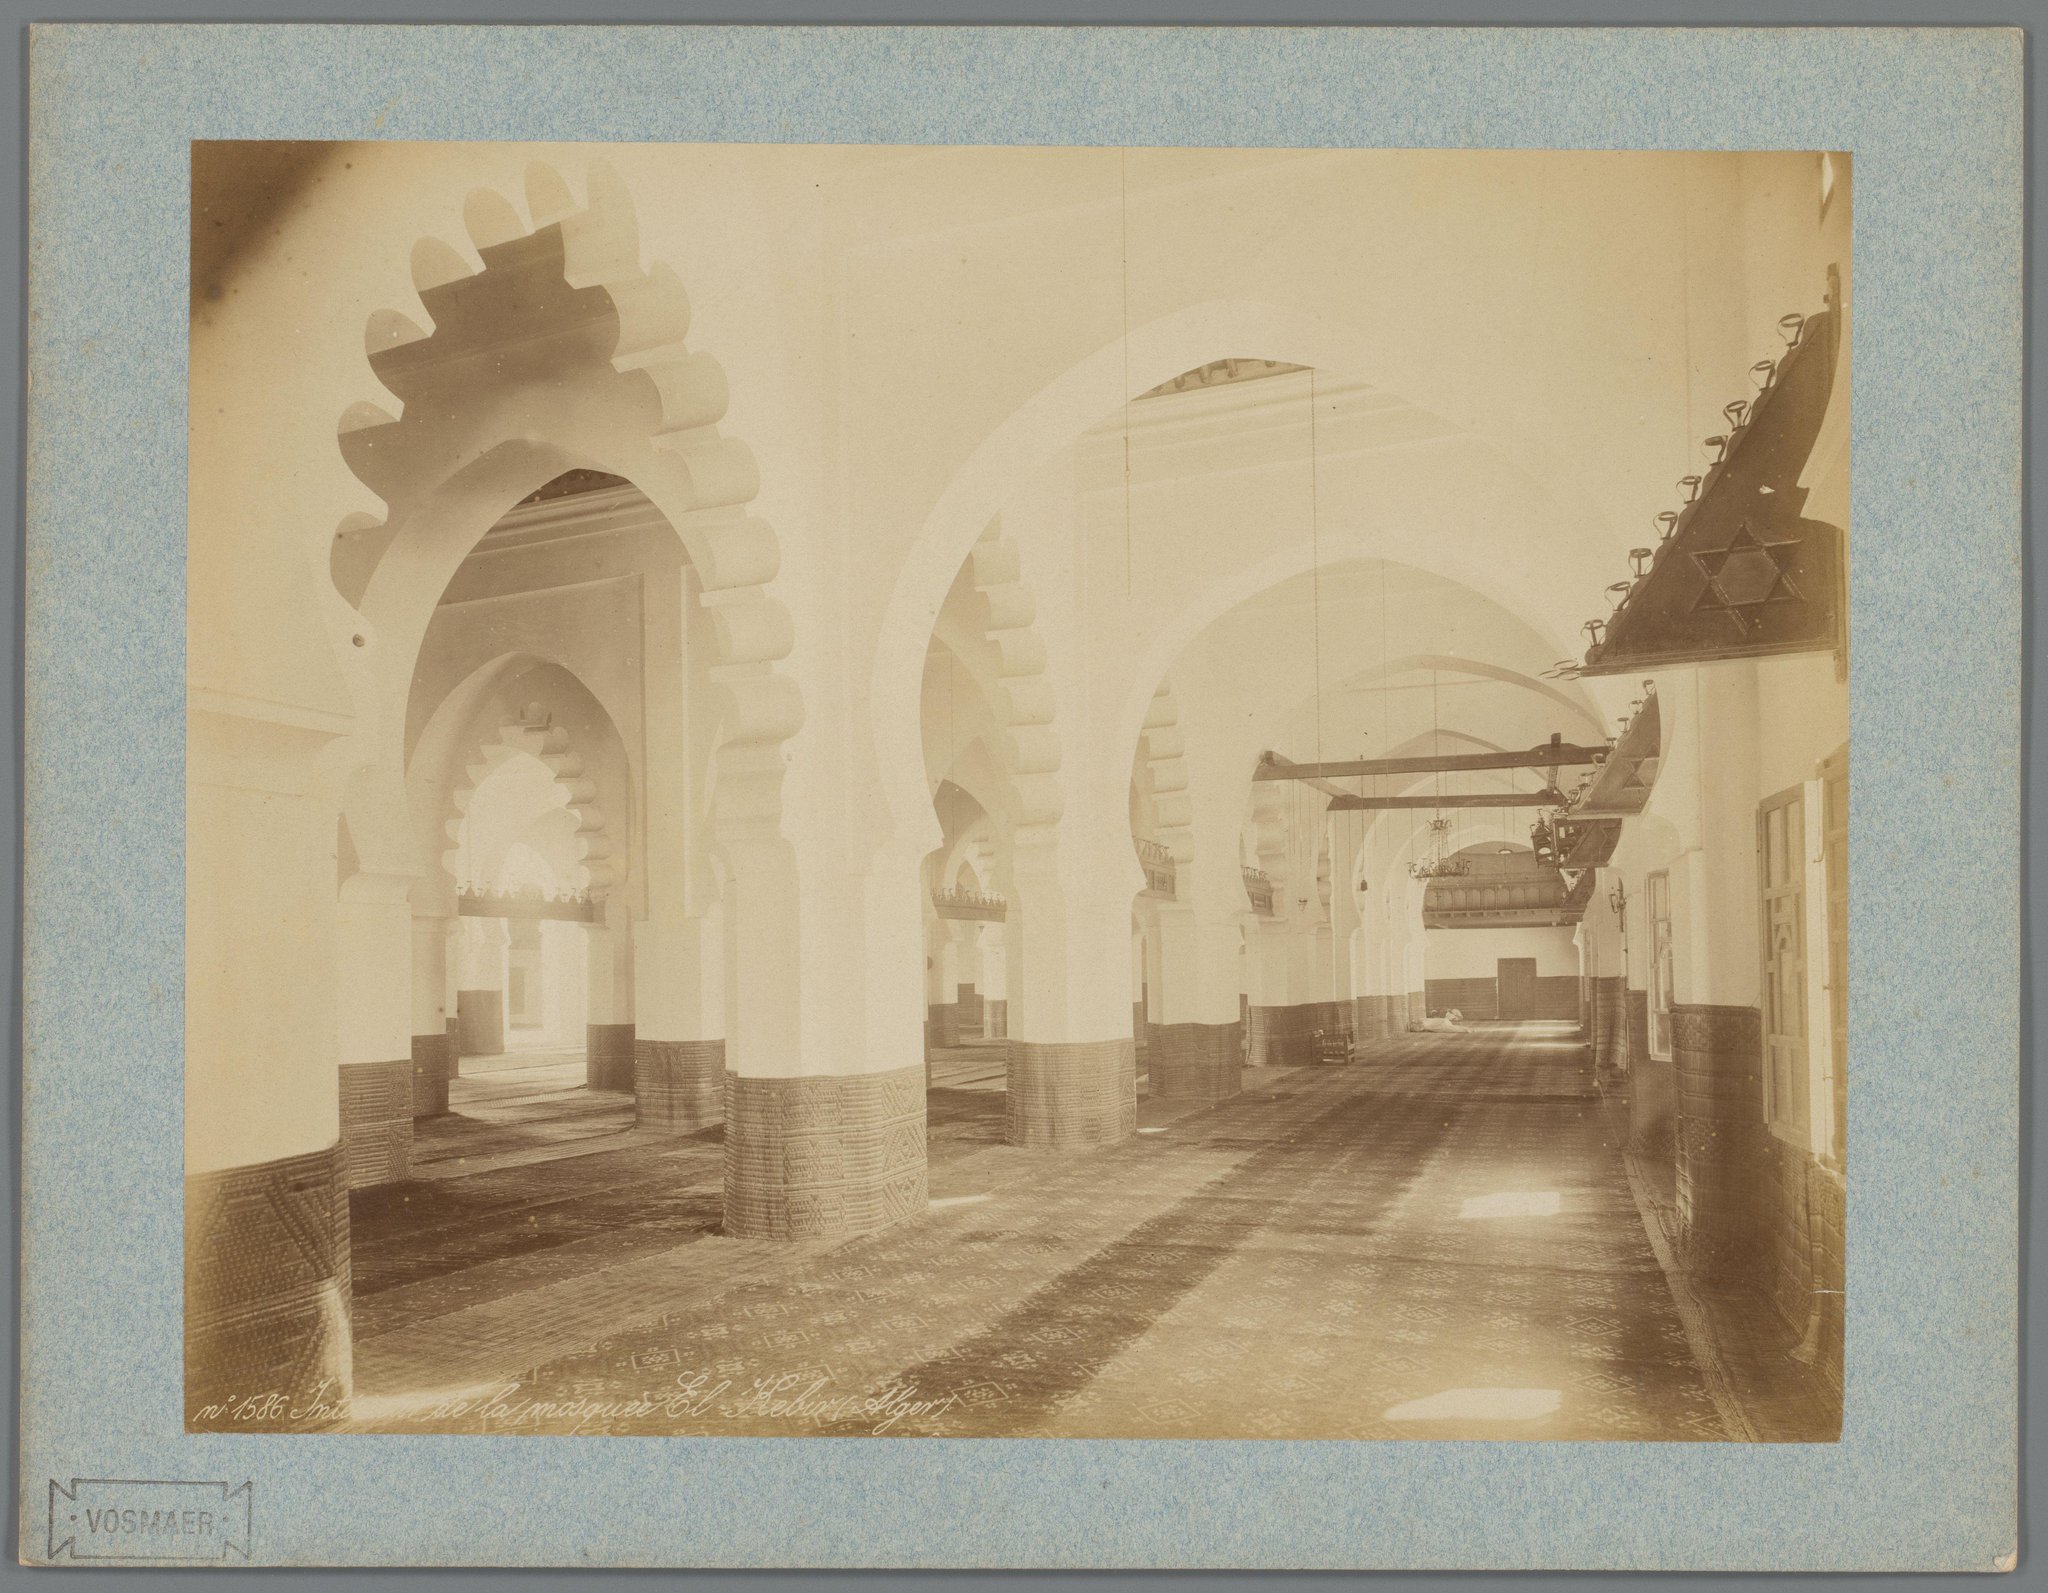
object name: photograph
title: Interieur van de Djamaa el Kebir-moskee in Algiers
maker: Anonymous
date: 1851-1900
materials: cardboard, paper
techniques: albumen print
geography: algiers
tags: temple, shrine ~ islam, mohammedanism, interior ~ representation of a building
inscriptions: collector's mark: ‘VOSMAER’, number: ‘n 1586’